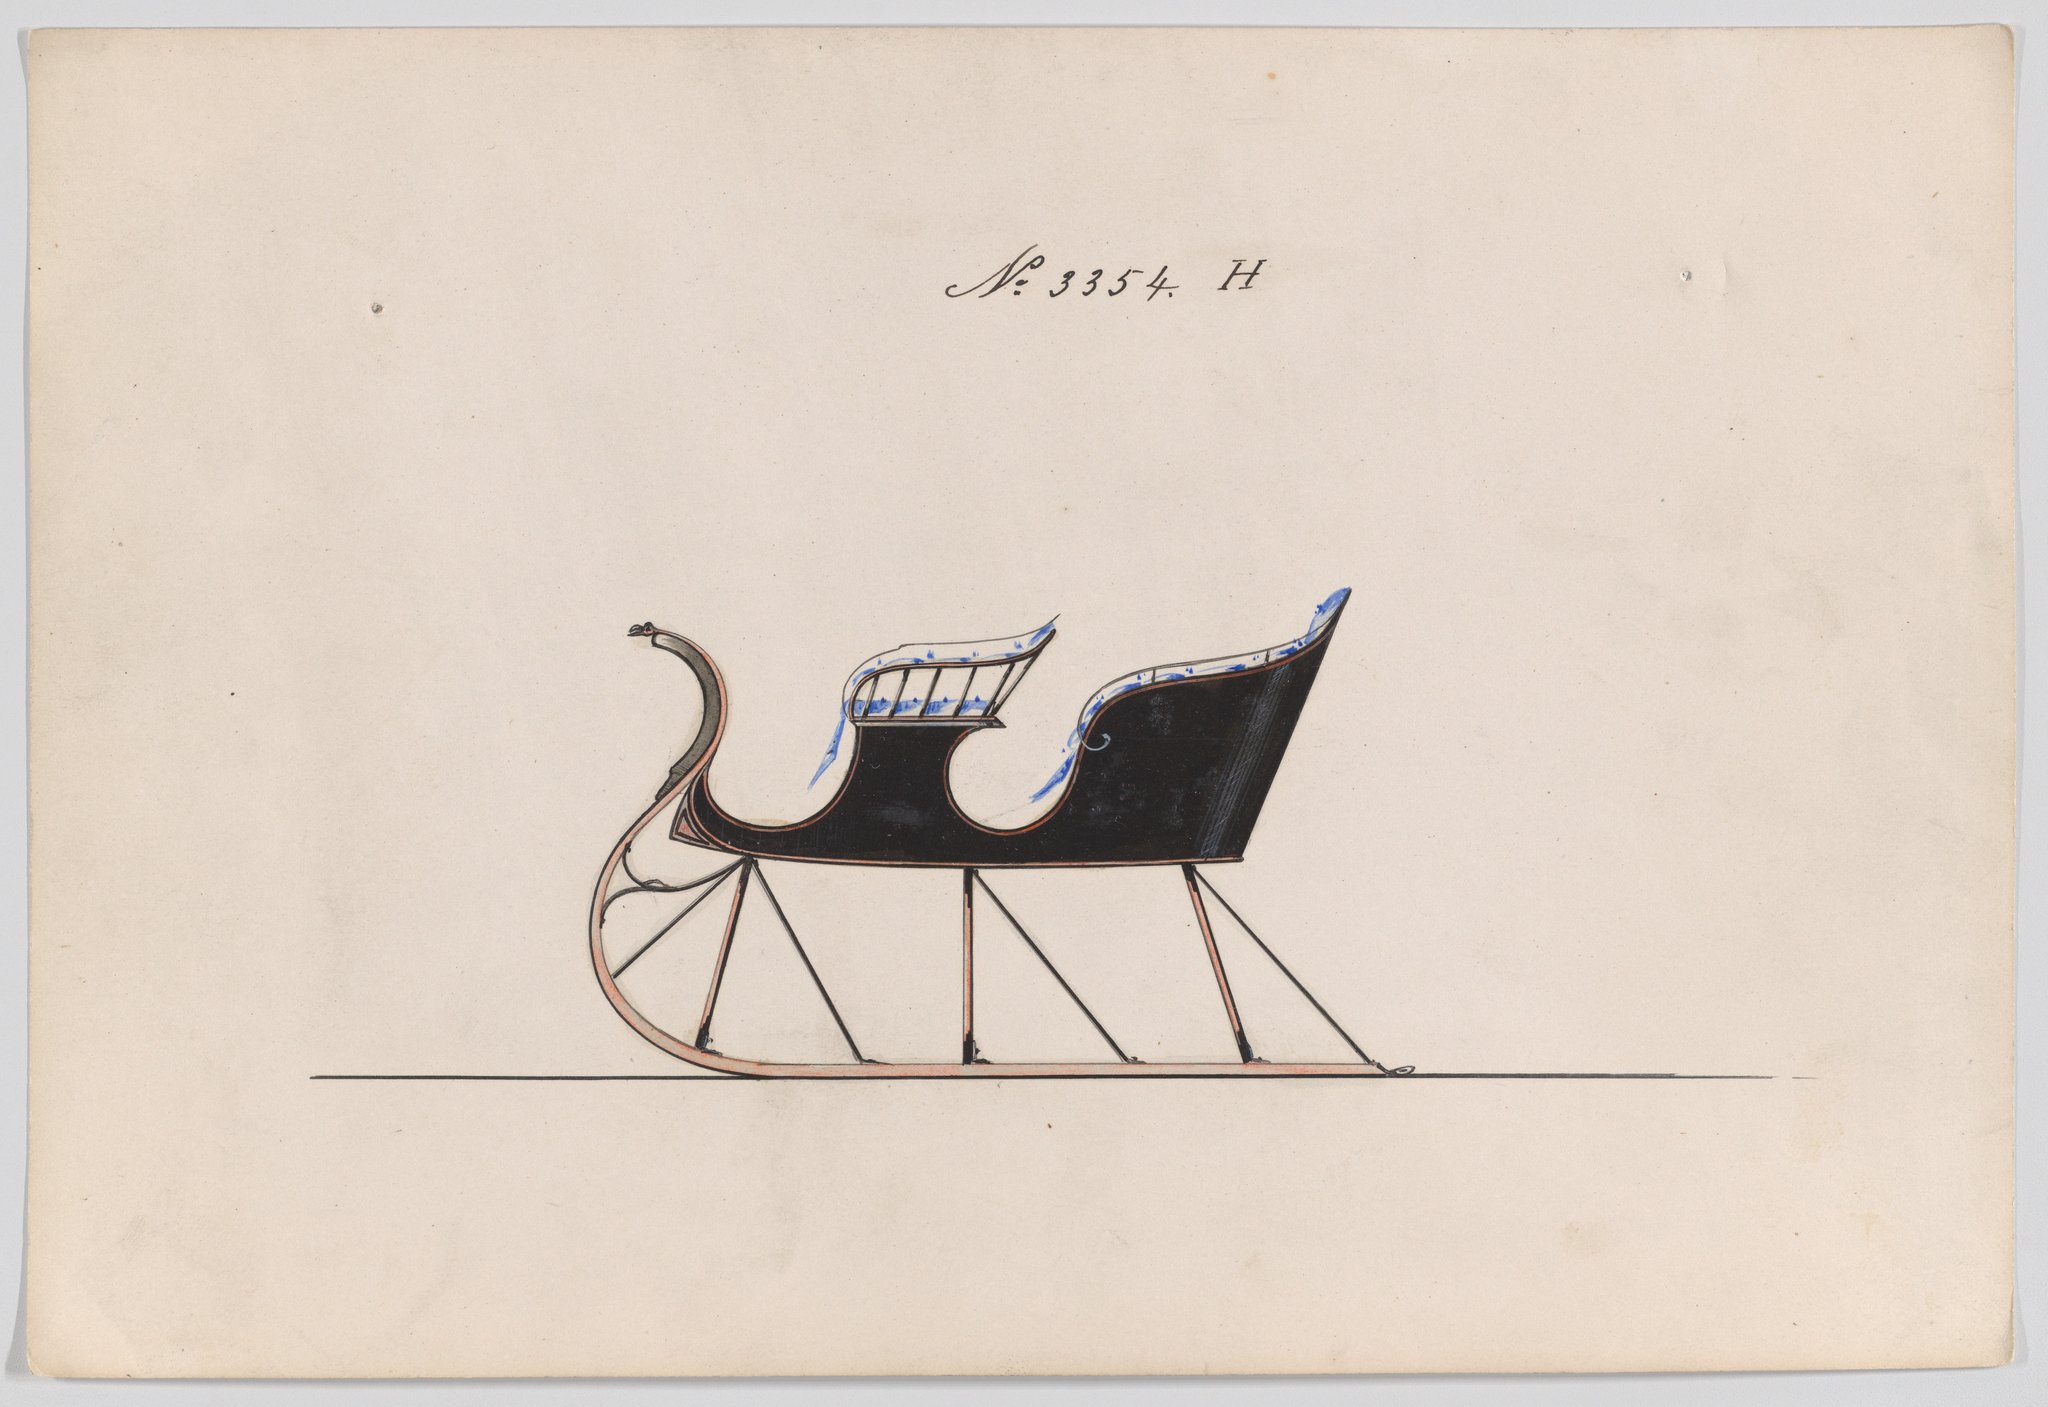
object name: drawing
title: Sleigh #3354 H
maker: brewster & co.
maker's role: manufacturer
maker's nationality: american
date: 1877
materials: gouache, gum arabic, ink, watercolor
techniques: pen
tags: sleighs